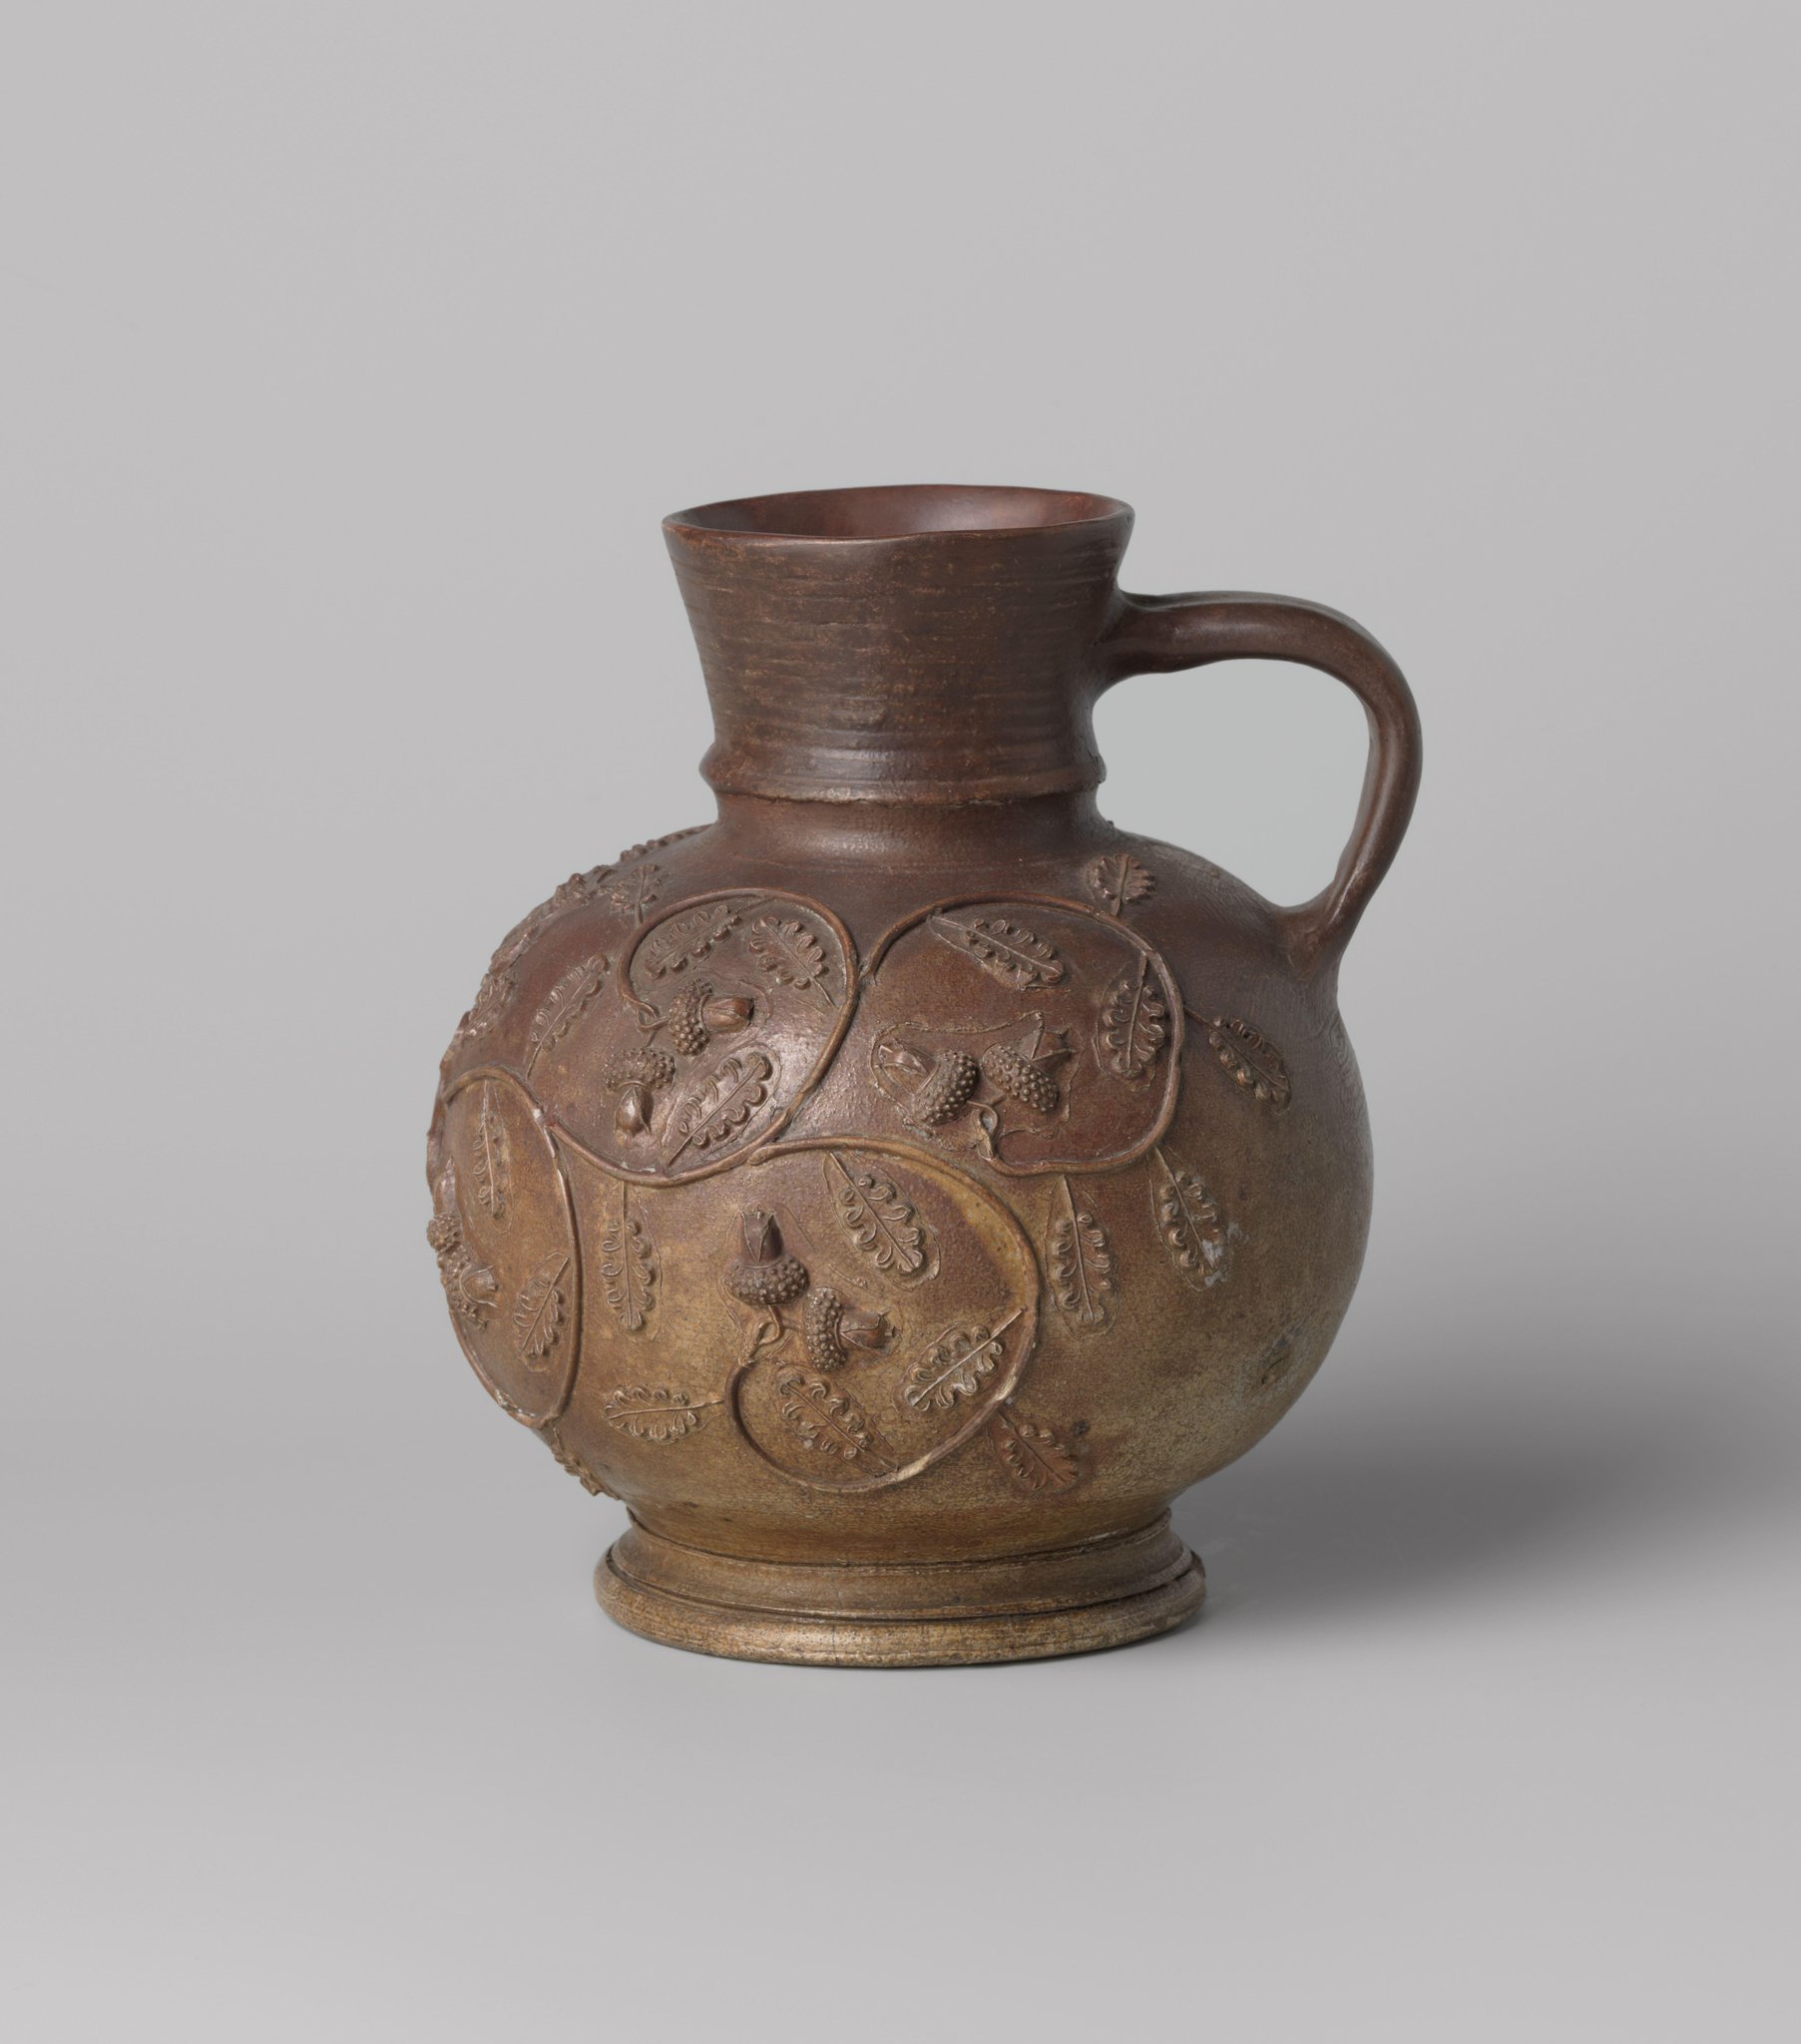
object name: jug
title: Jug with a coat of arms and oak scrolls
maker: Anonymous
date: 1530-1560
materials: engobe, glaze, stoneware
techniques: firing, forming, relief, turning, vitrification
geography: cologne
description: Kan van steengoed op standring met een bolvormig lichaam en wijde, licht spreidende nek. Het C-vormige oor is bevestigd aan de nek en de schouder. Profielen op de nek en de voet. Bedekt met een bruine engobe. Op de buik in reliëf een gedrukt en opgelegd wapen tussen eikenranken. Keulen.